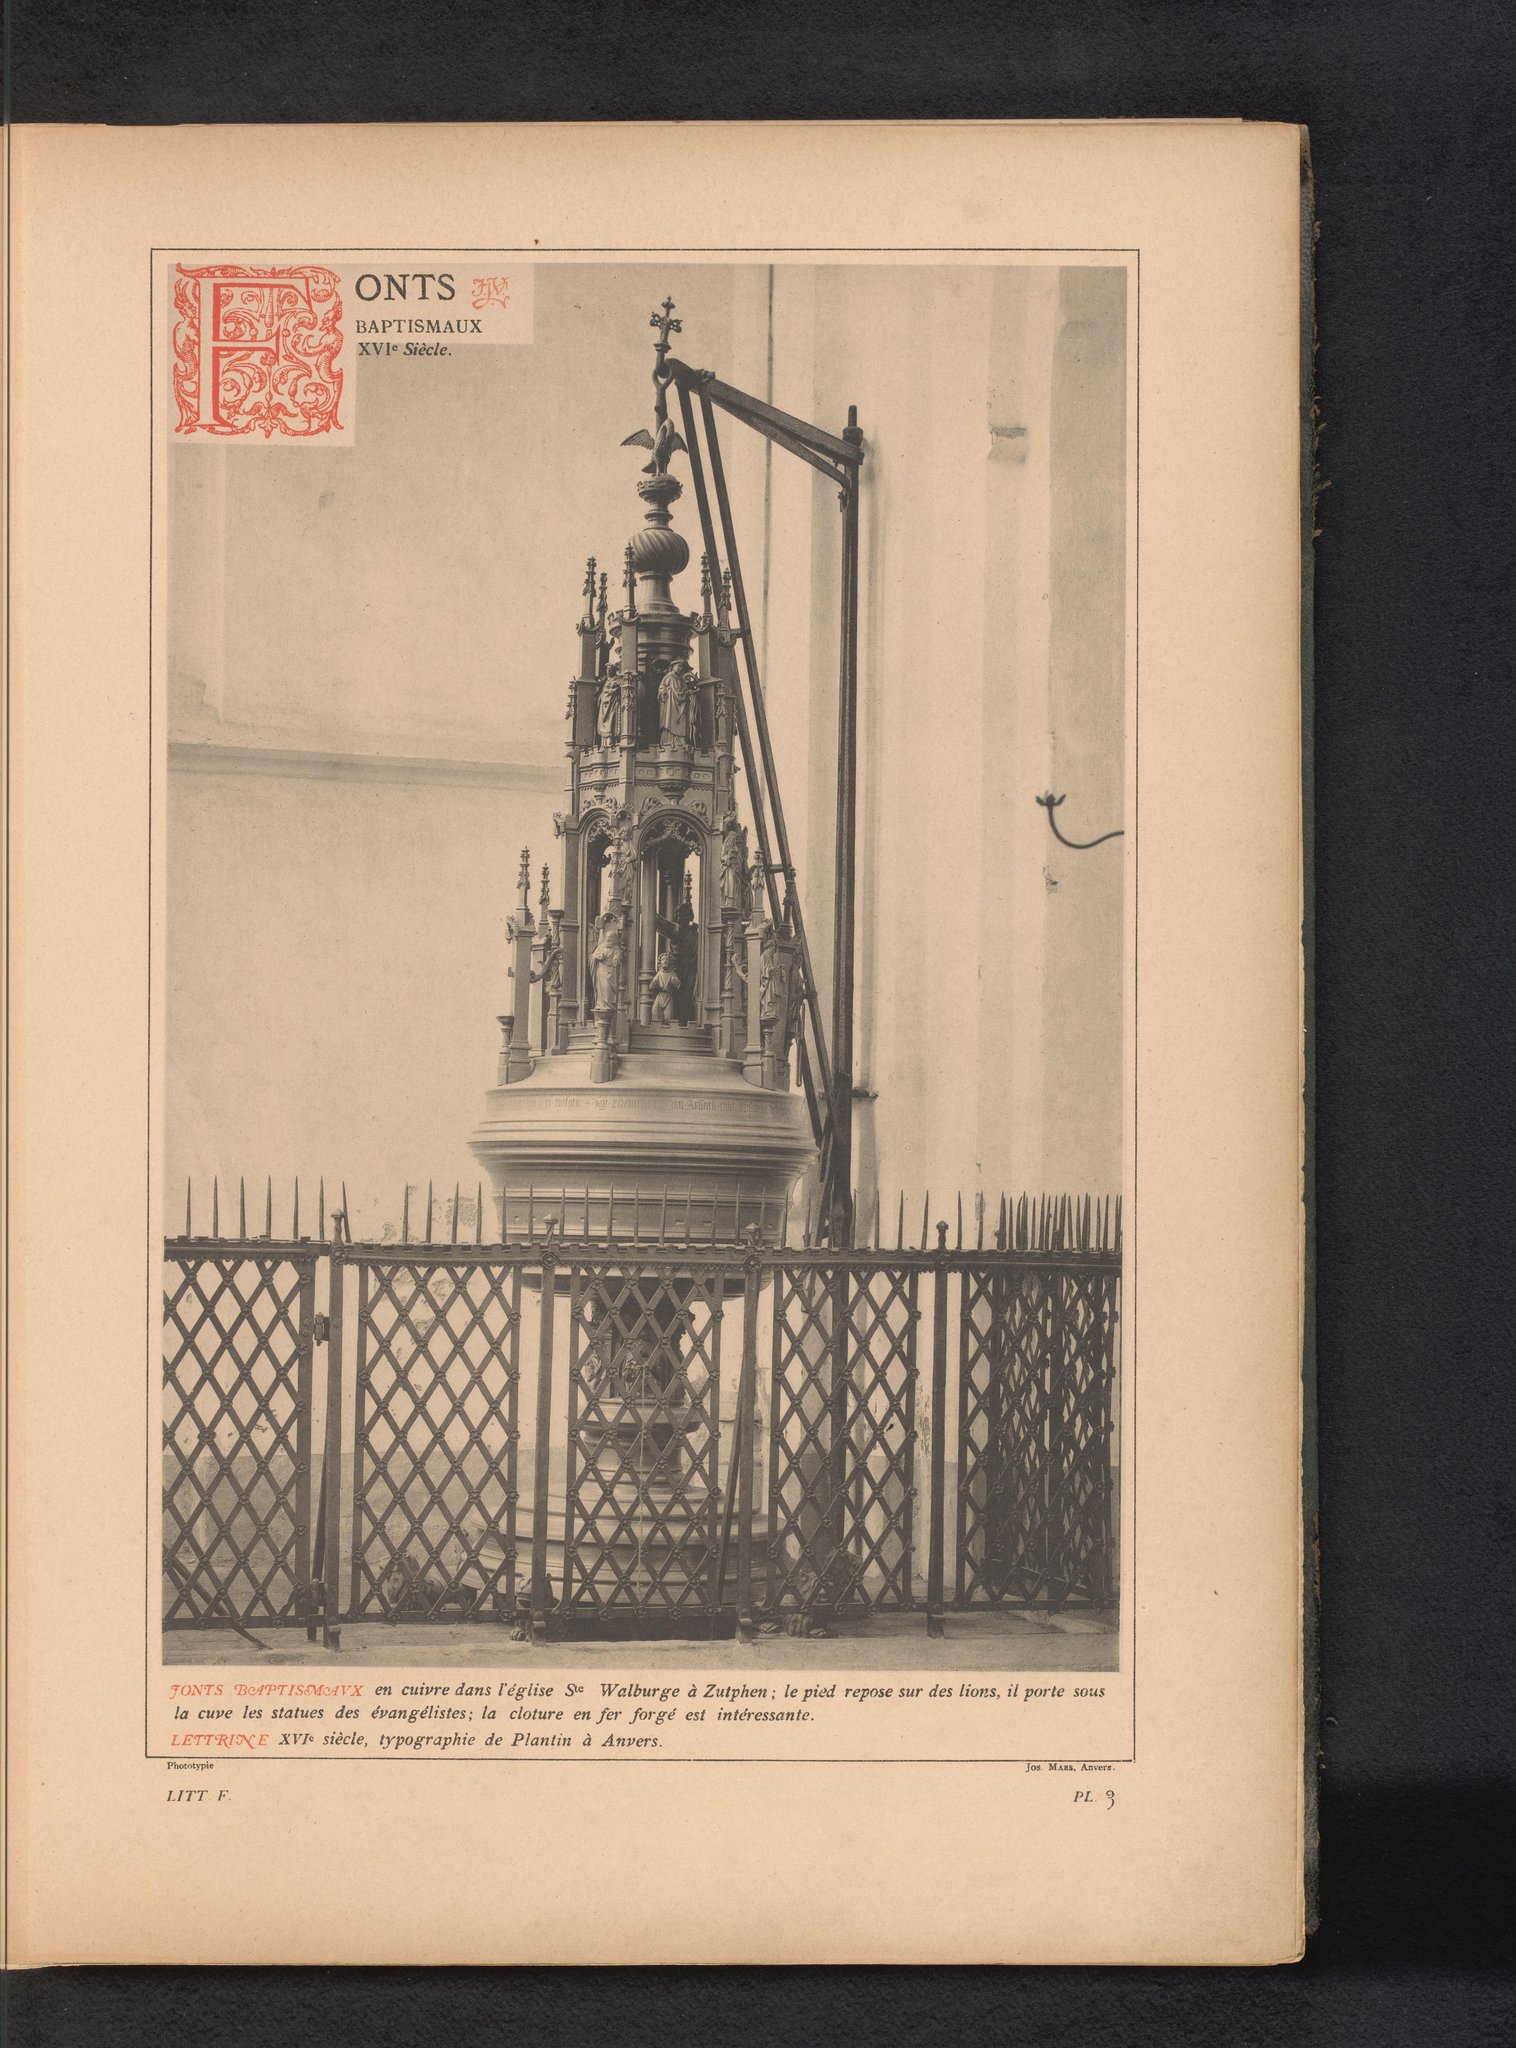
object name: photomechanical print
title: Koperen doopvont in de Sint Walburgiskerk in Zutphen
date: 1875-1880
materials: paper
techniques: photograph, photolithography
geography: antwerp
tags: baptismal font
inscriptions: inscription: ‘LITT. F. - PL. 3’, inscription: ‘FONTS BAPTISMAUX en (...)’, monogram: ‘JJvY’